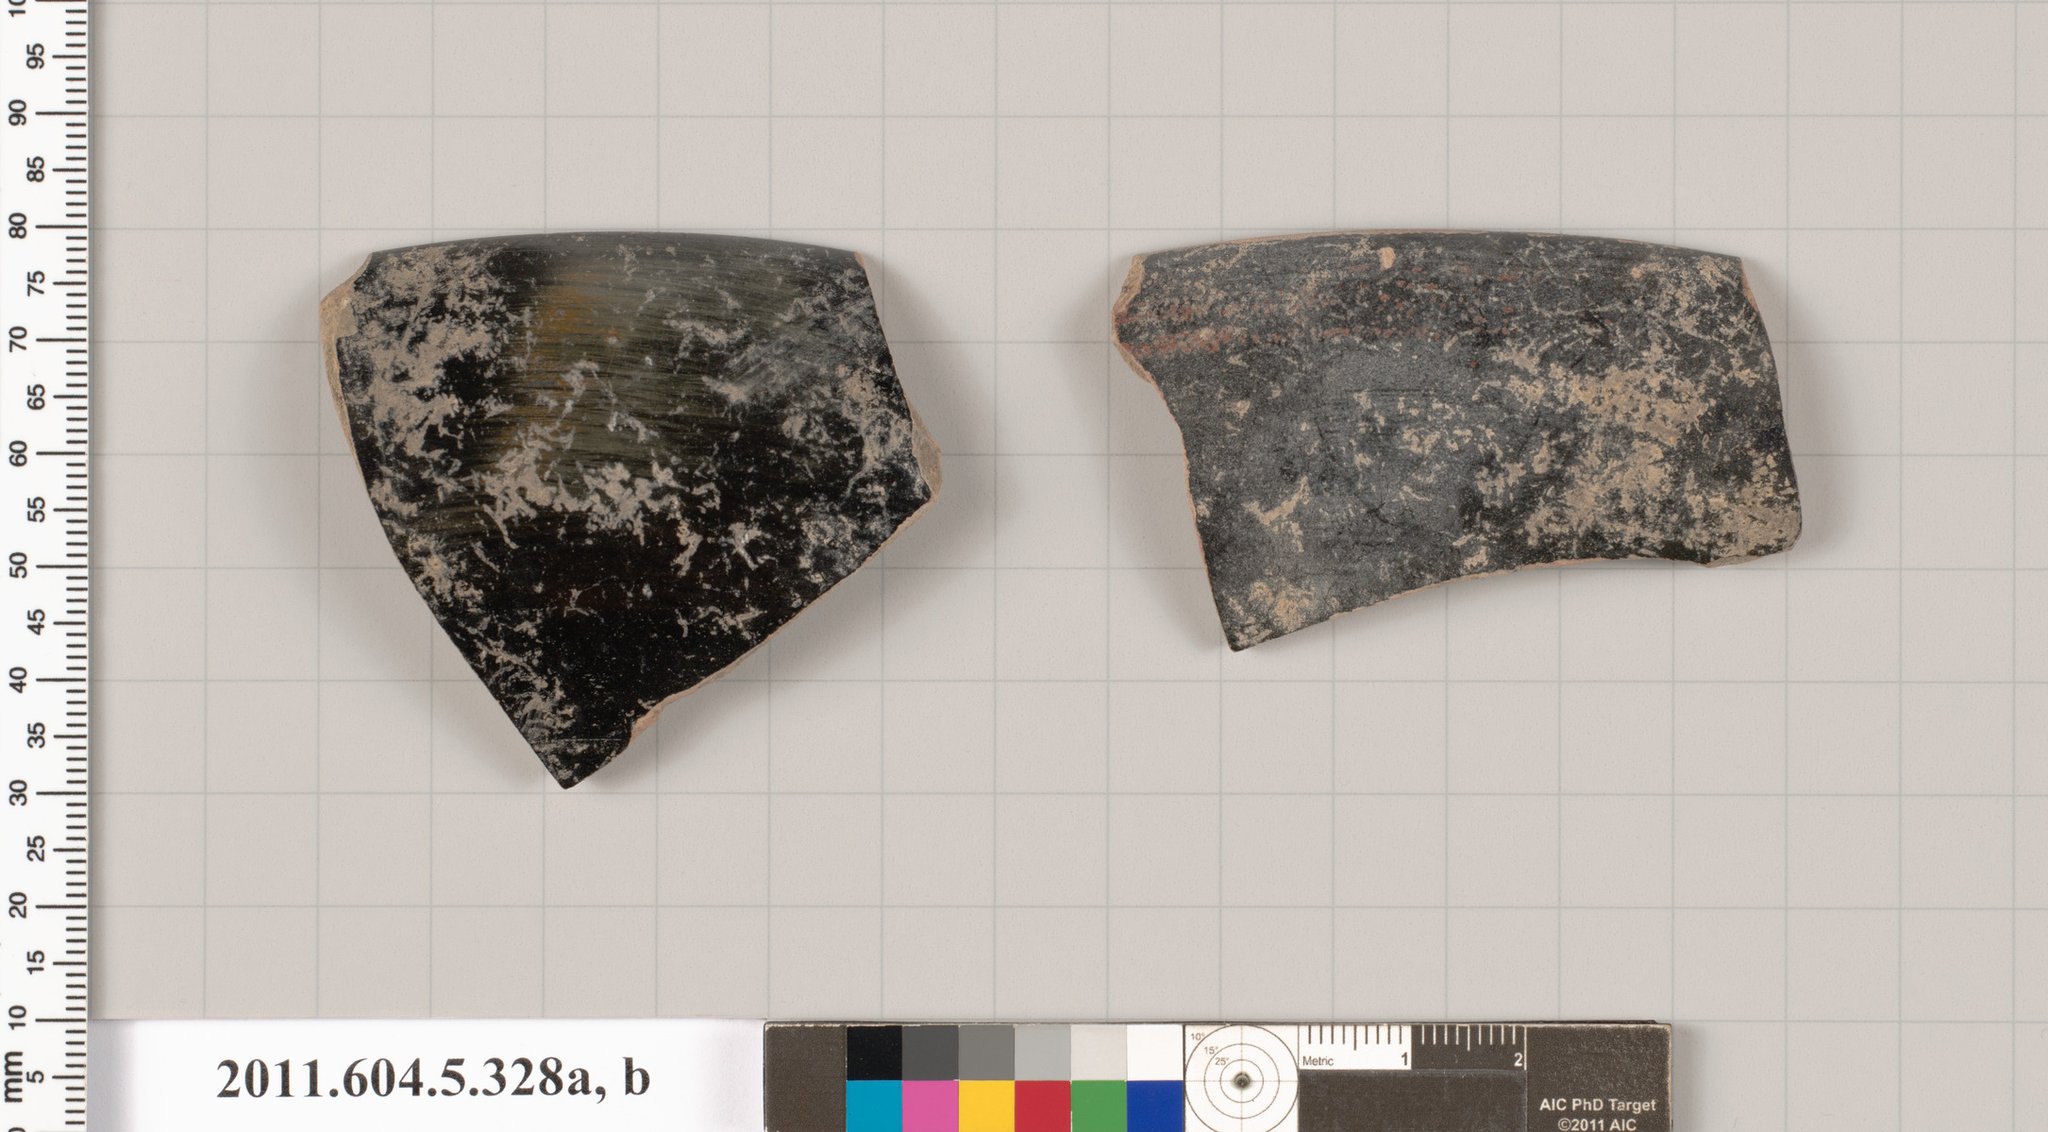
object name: kylix fragment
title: Terracotta rim fragments of a kylix (drinking cup)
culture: greek, attic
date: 600-401 BCE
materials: terracotta